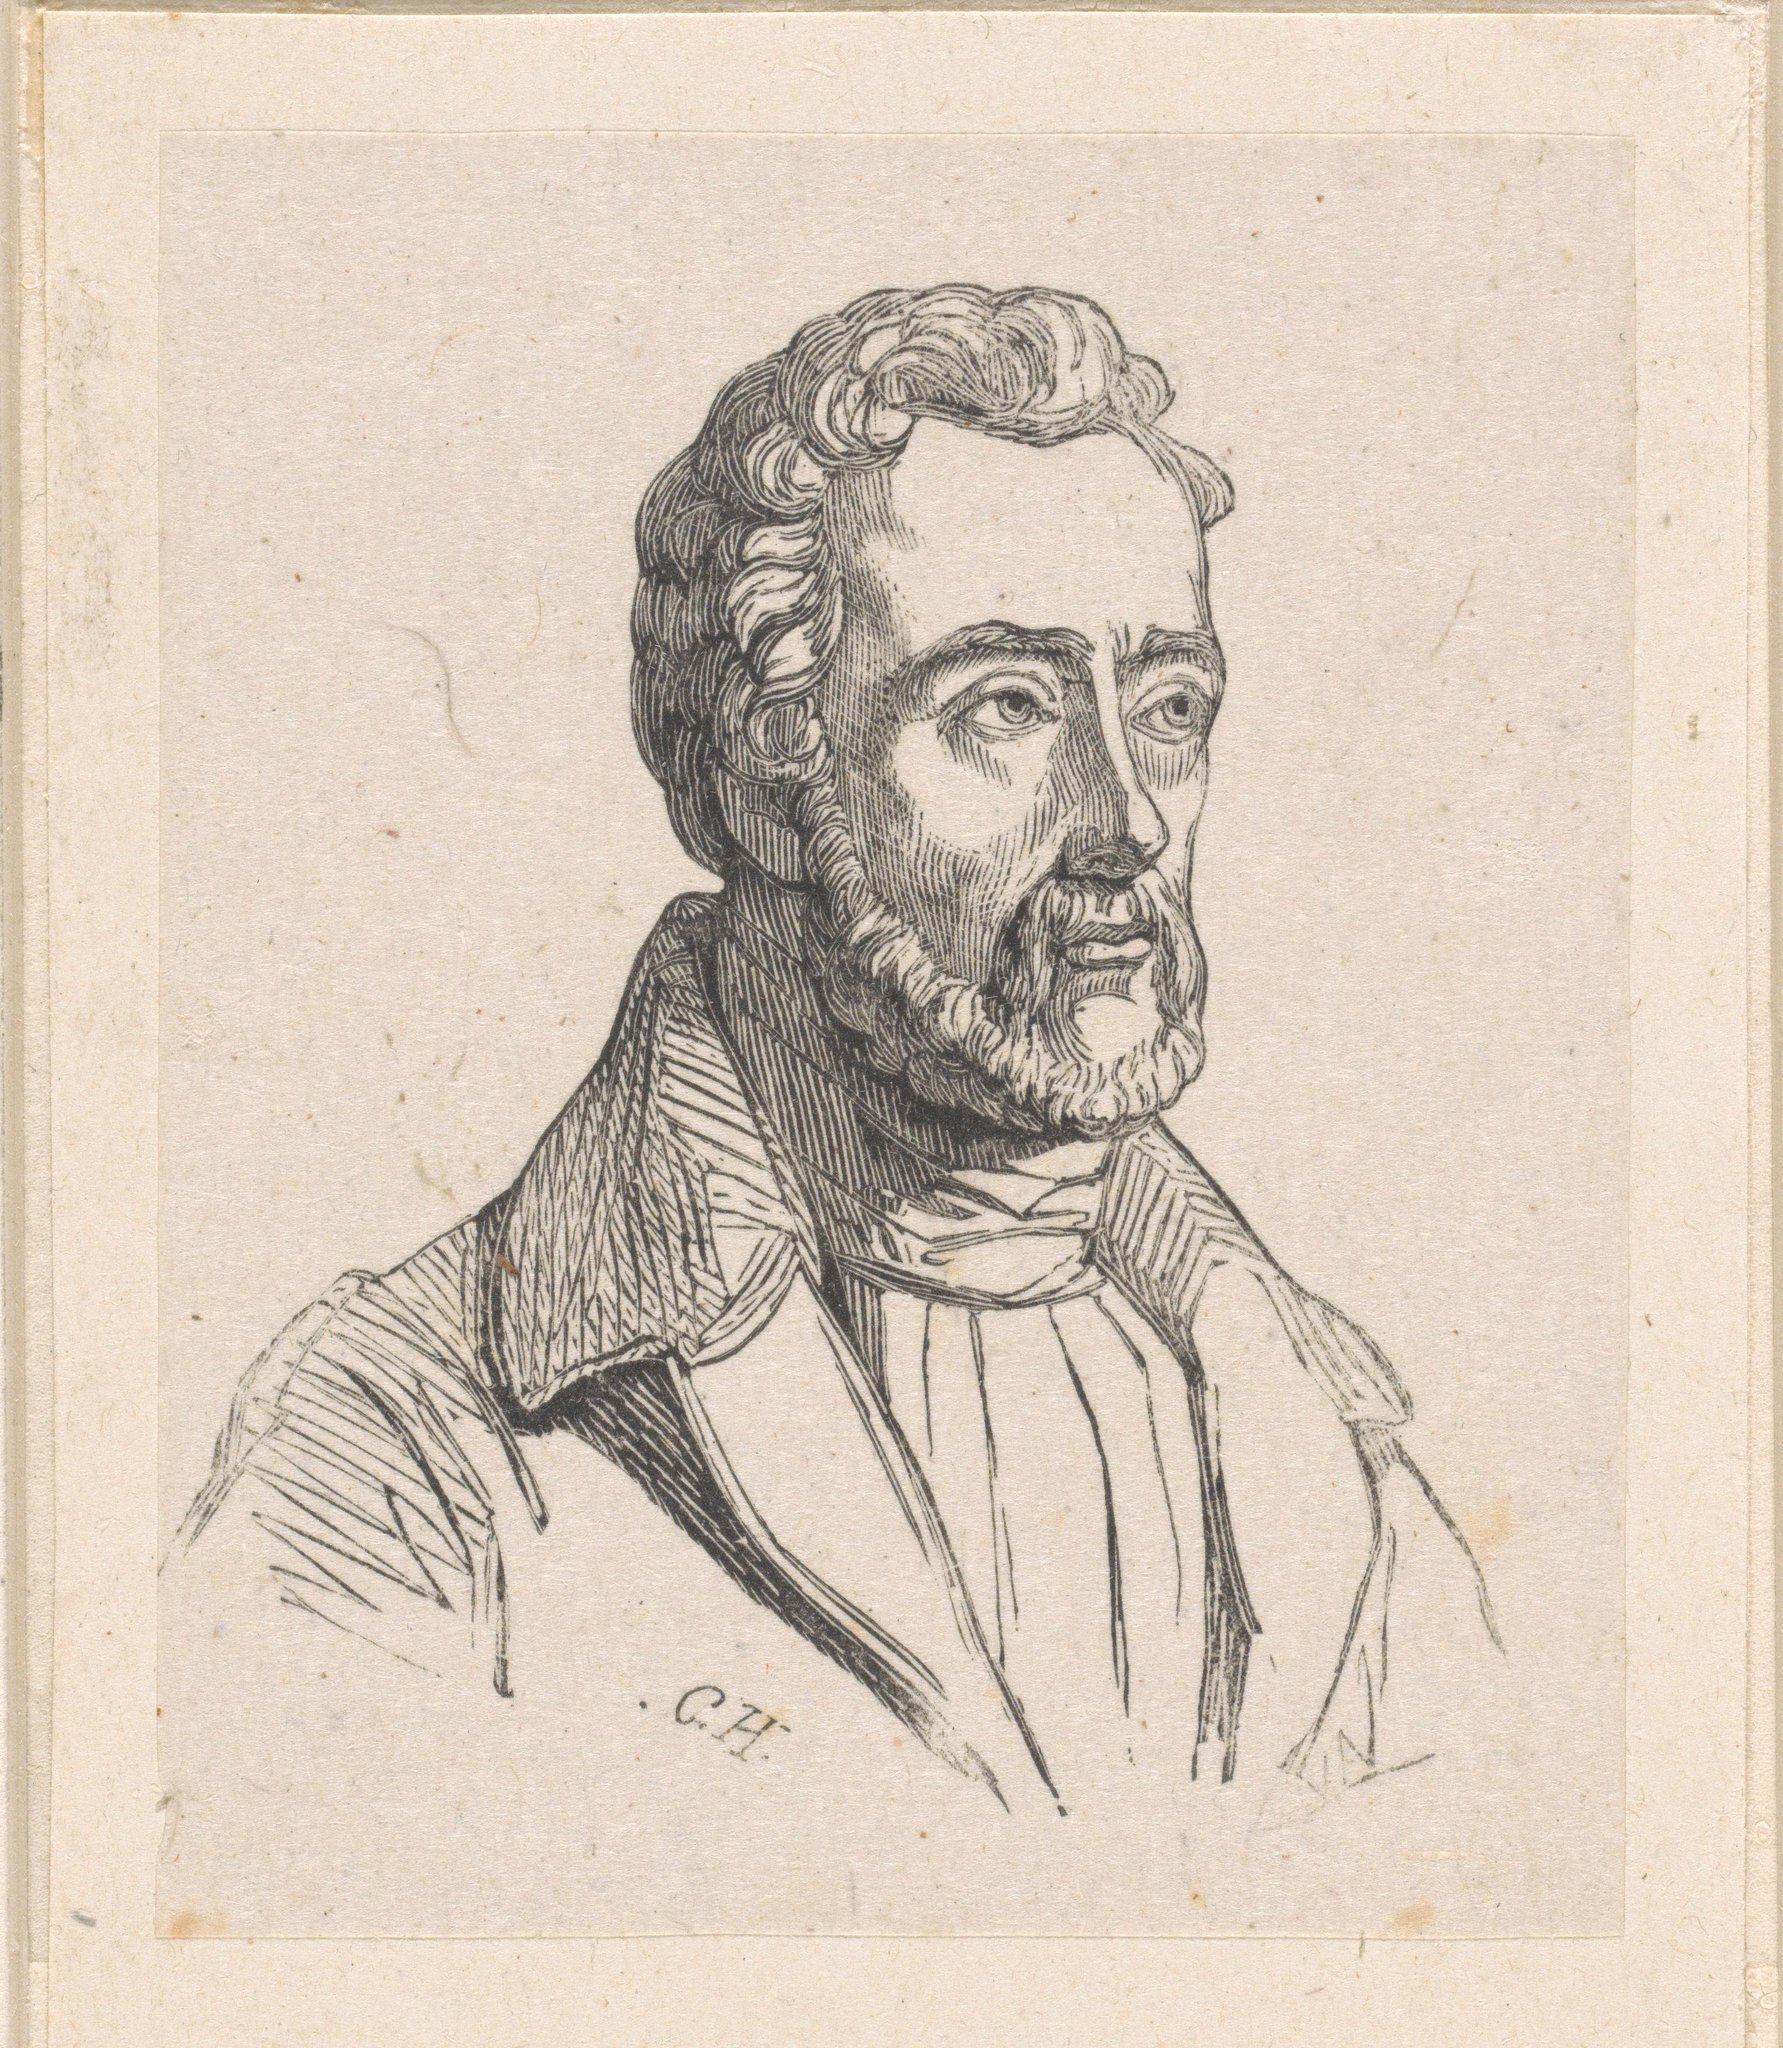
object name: print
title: Portret van Henry Scheffer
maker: Anonymous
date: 1805-1908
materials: paper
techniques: engraving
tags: the hague, paris, draughtsman, henry scheffer, historical persons, portrait, self-portrait of artist